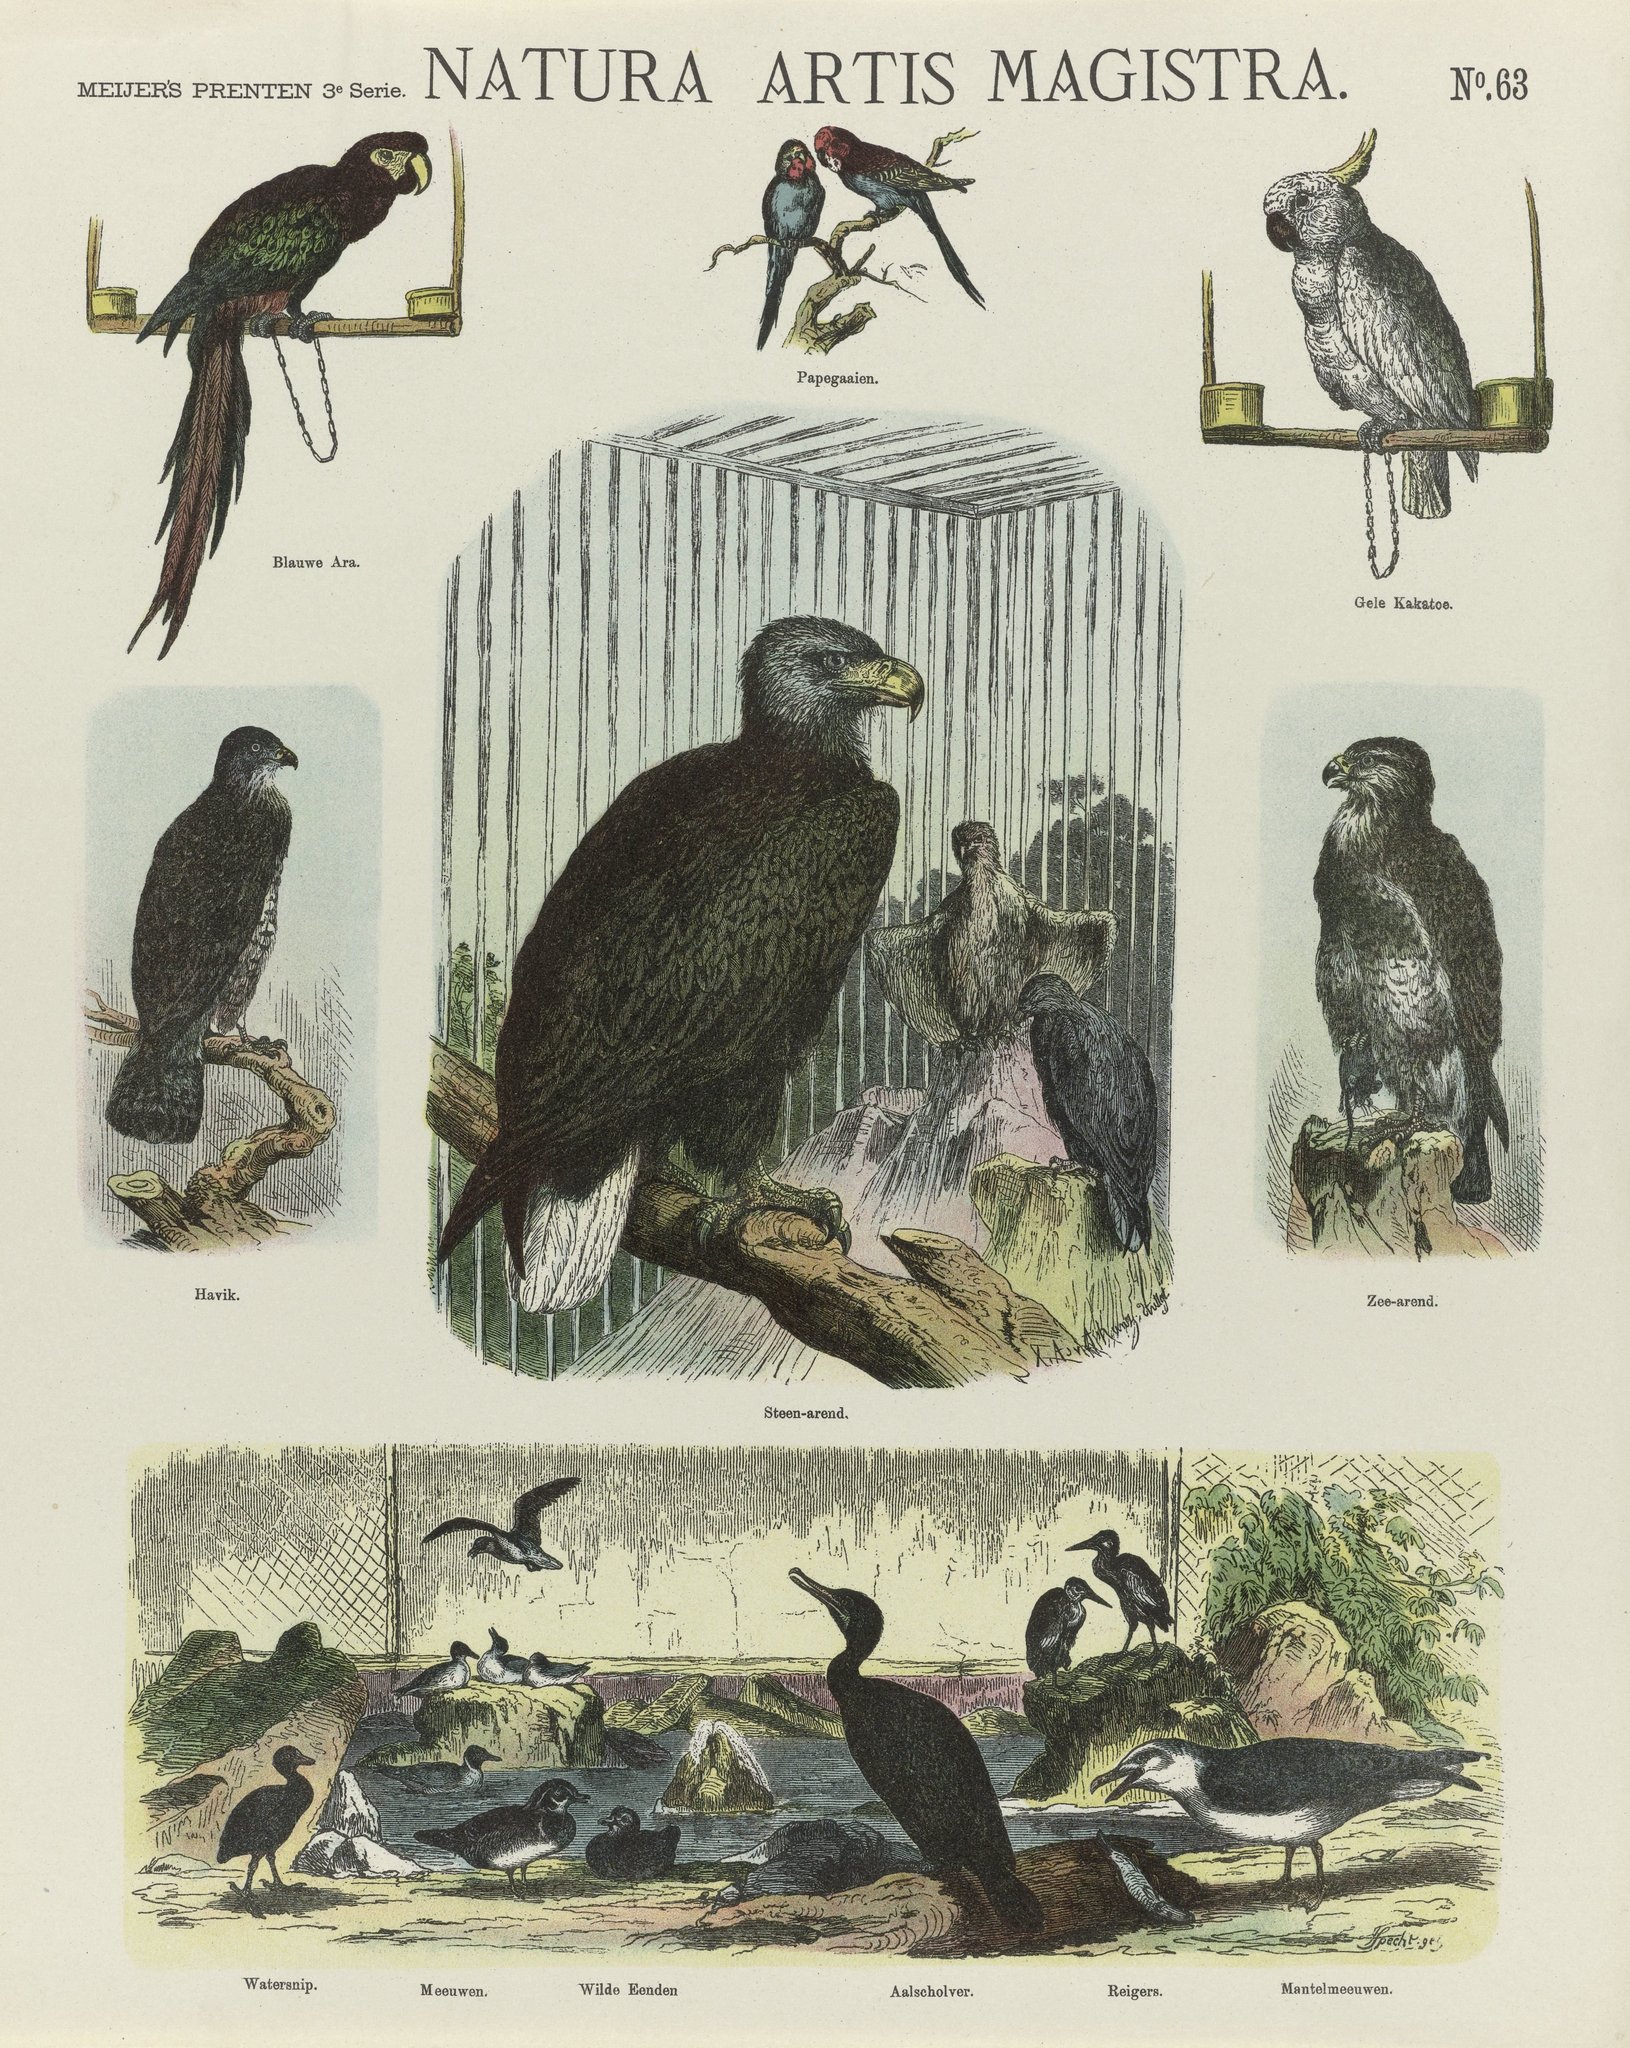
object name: popular print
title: Natura artis magistra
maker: specht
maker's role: print maker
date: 1878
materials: paper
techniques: lithograph, letterpress printing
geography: amsterdam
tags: predatory birds: eagle, birds, ornamental birds: parrot, water-birds: duck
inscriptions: collector's mark: Lugt 2760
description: Blad met 7 voorstellingen van vogels, waaronder een ara, een kaketoe en een reiger. Onder elke afbeelding een onderschrift. Genummerd rechtsboven: No. 63.